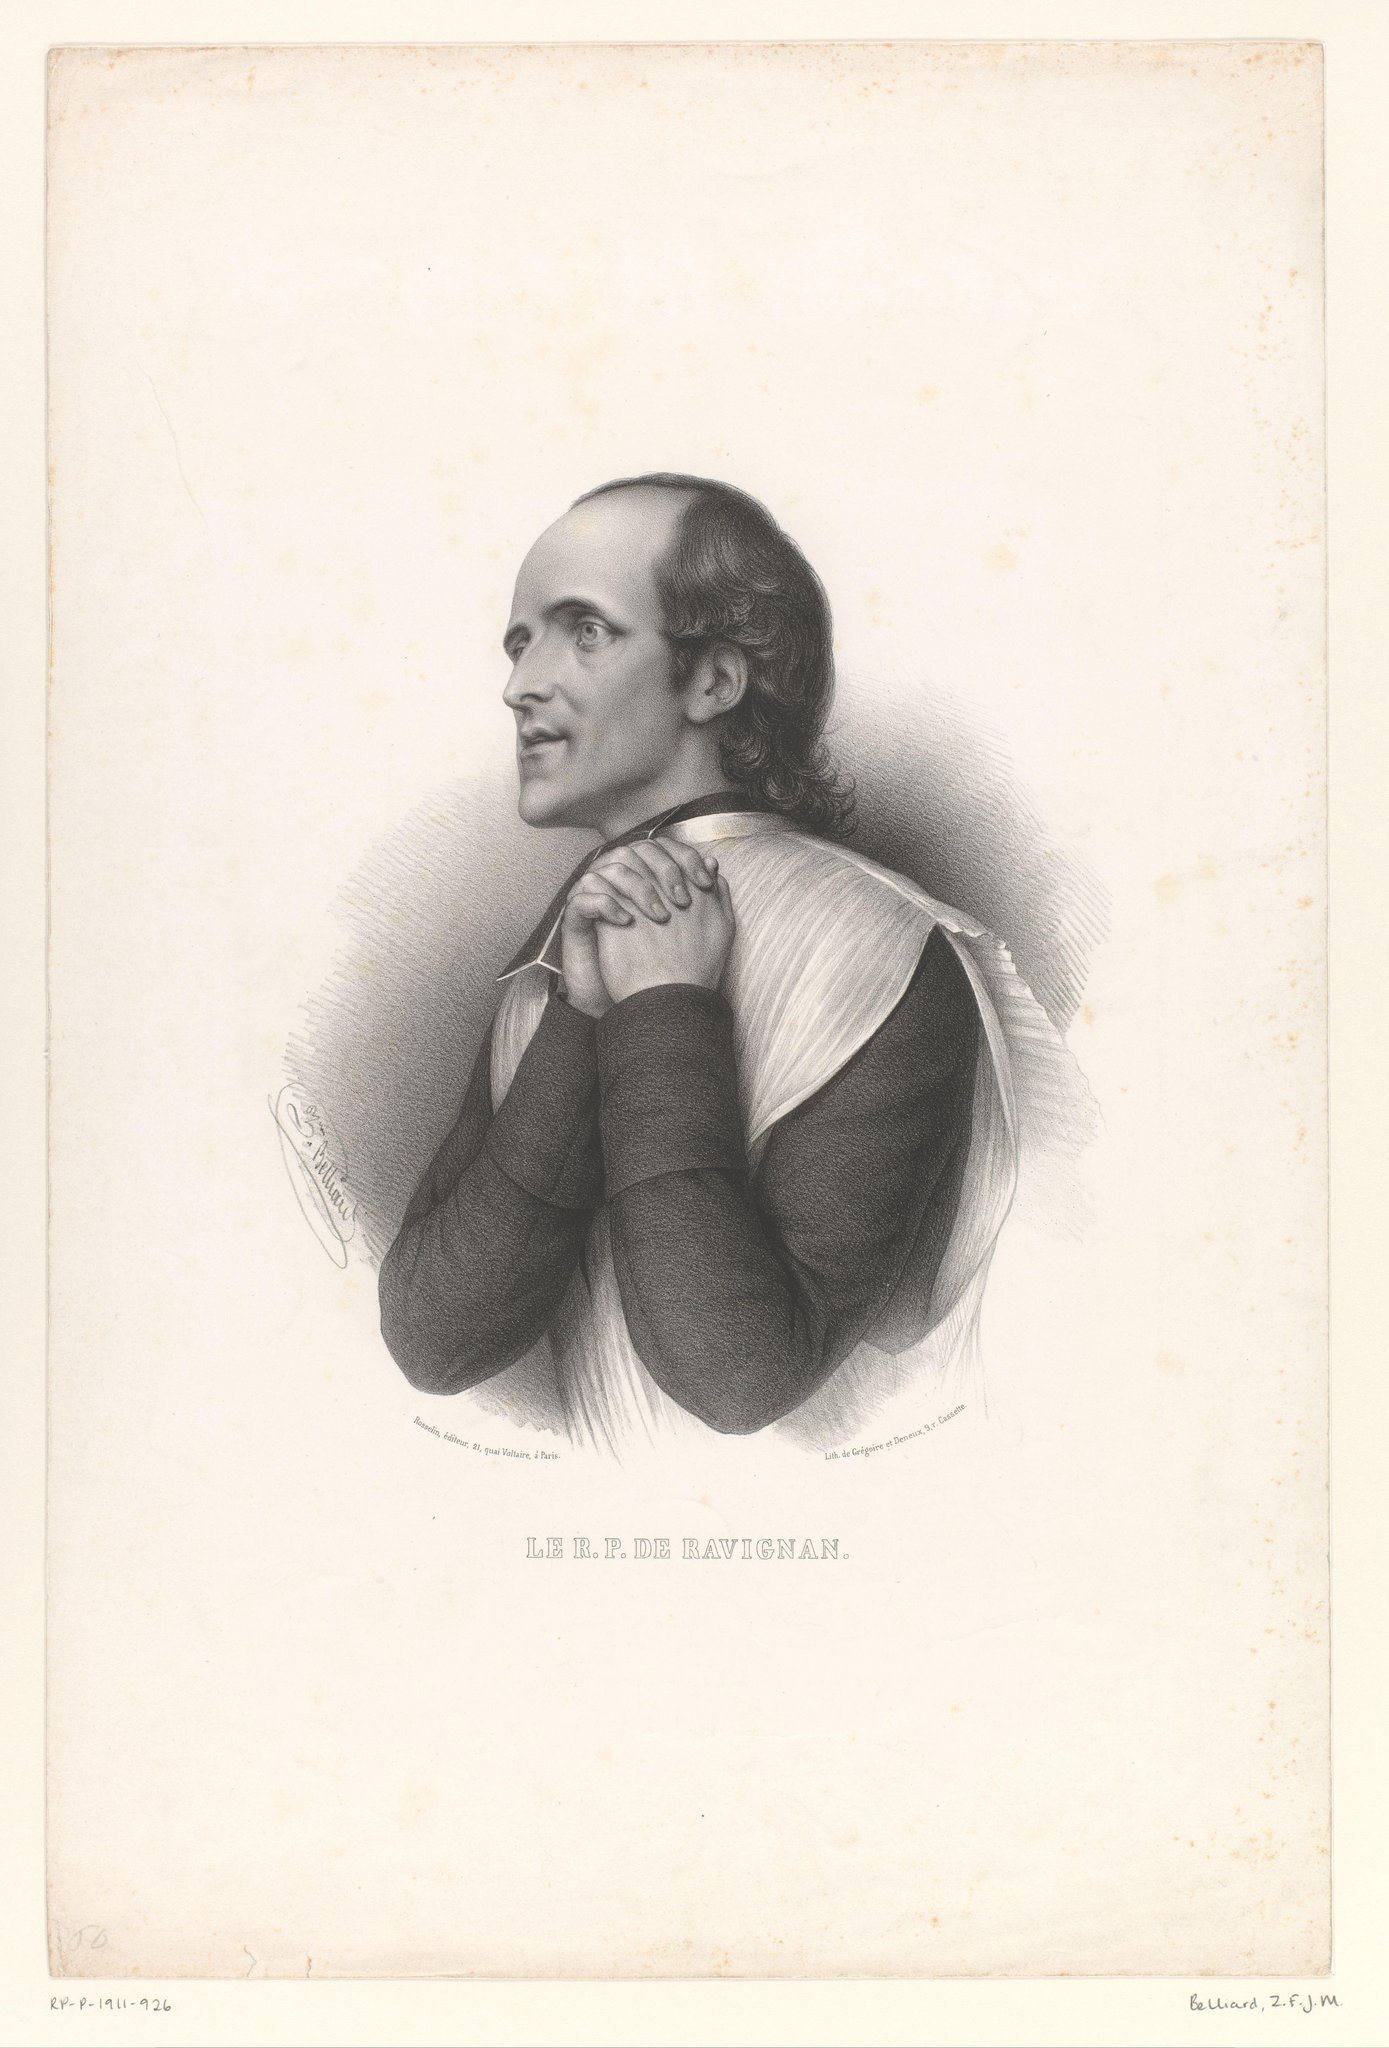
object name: print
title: Beroemdheden van deze tijd 2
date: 1844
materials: paper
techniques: lithograph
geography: paris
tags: paris, priest, historical persons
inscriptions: collector's mark: Lugt 2228a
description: Prent gepubliceerd in: Antoine Maurin, Célébrités contemporaines ou portraits des personnes de notre époque, lithographiés par M.M. Maurin et Belliard, et publiées par Madame Delpech, dl. 2, Parijs 1842.